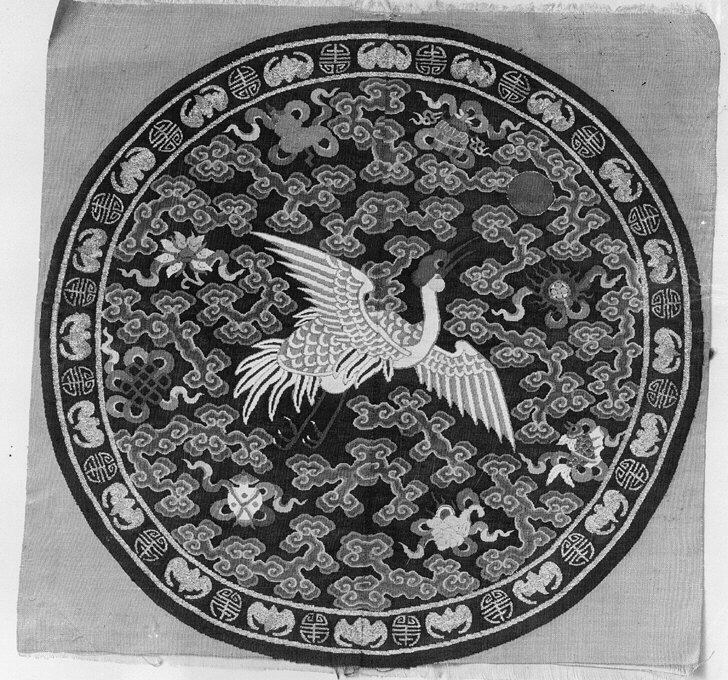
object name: insignia medallion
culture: chinese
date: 1801-1900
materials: metal thread, silk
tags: birds